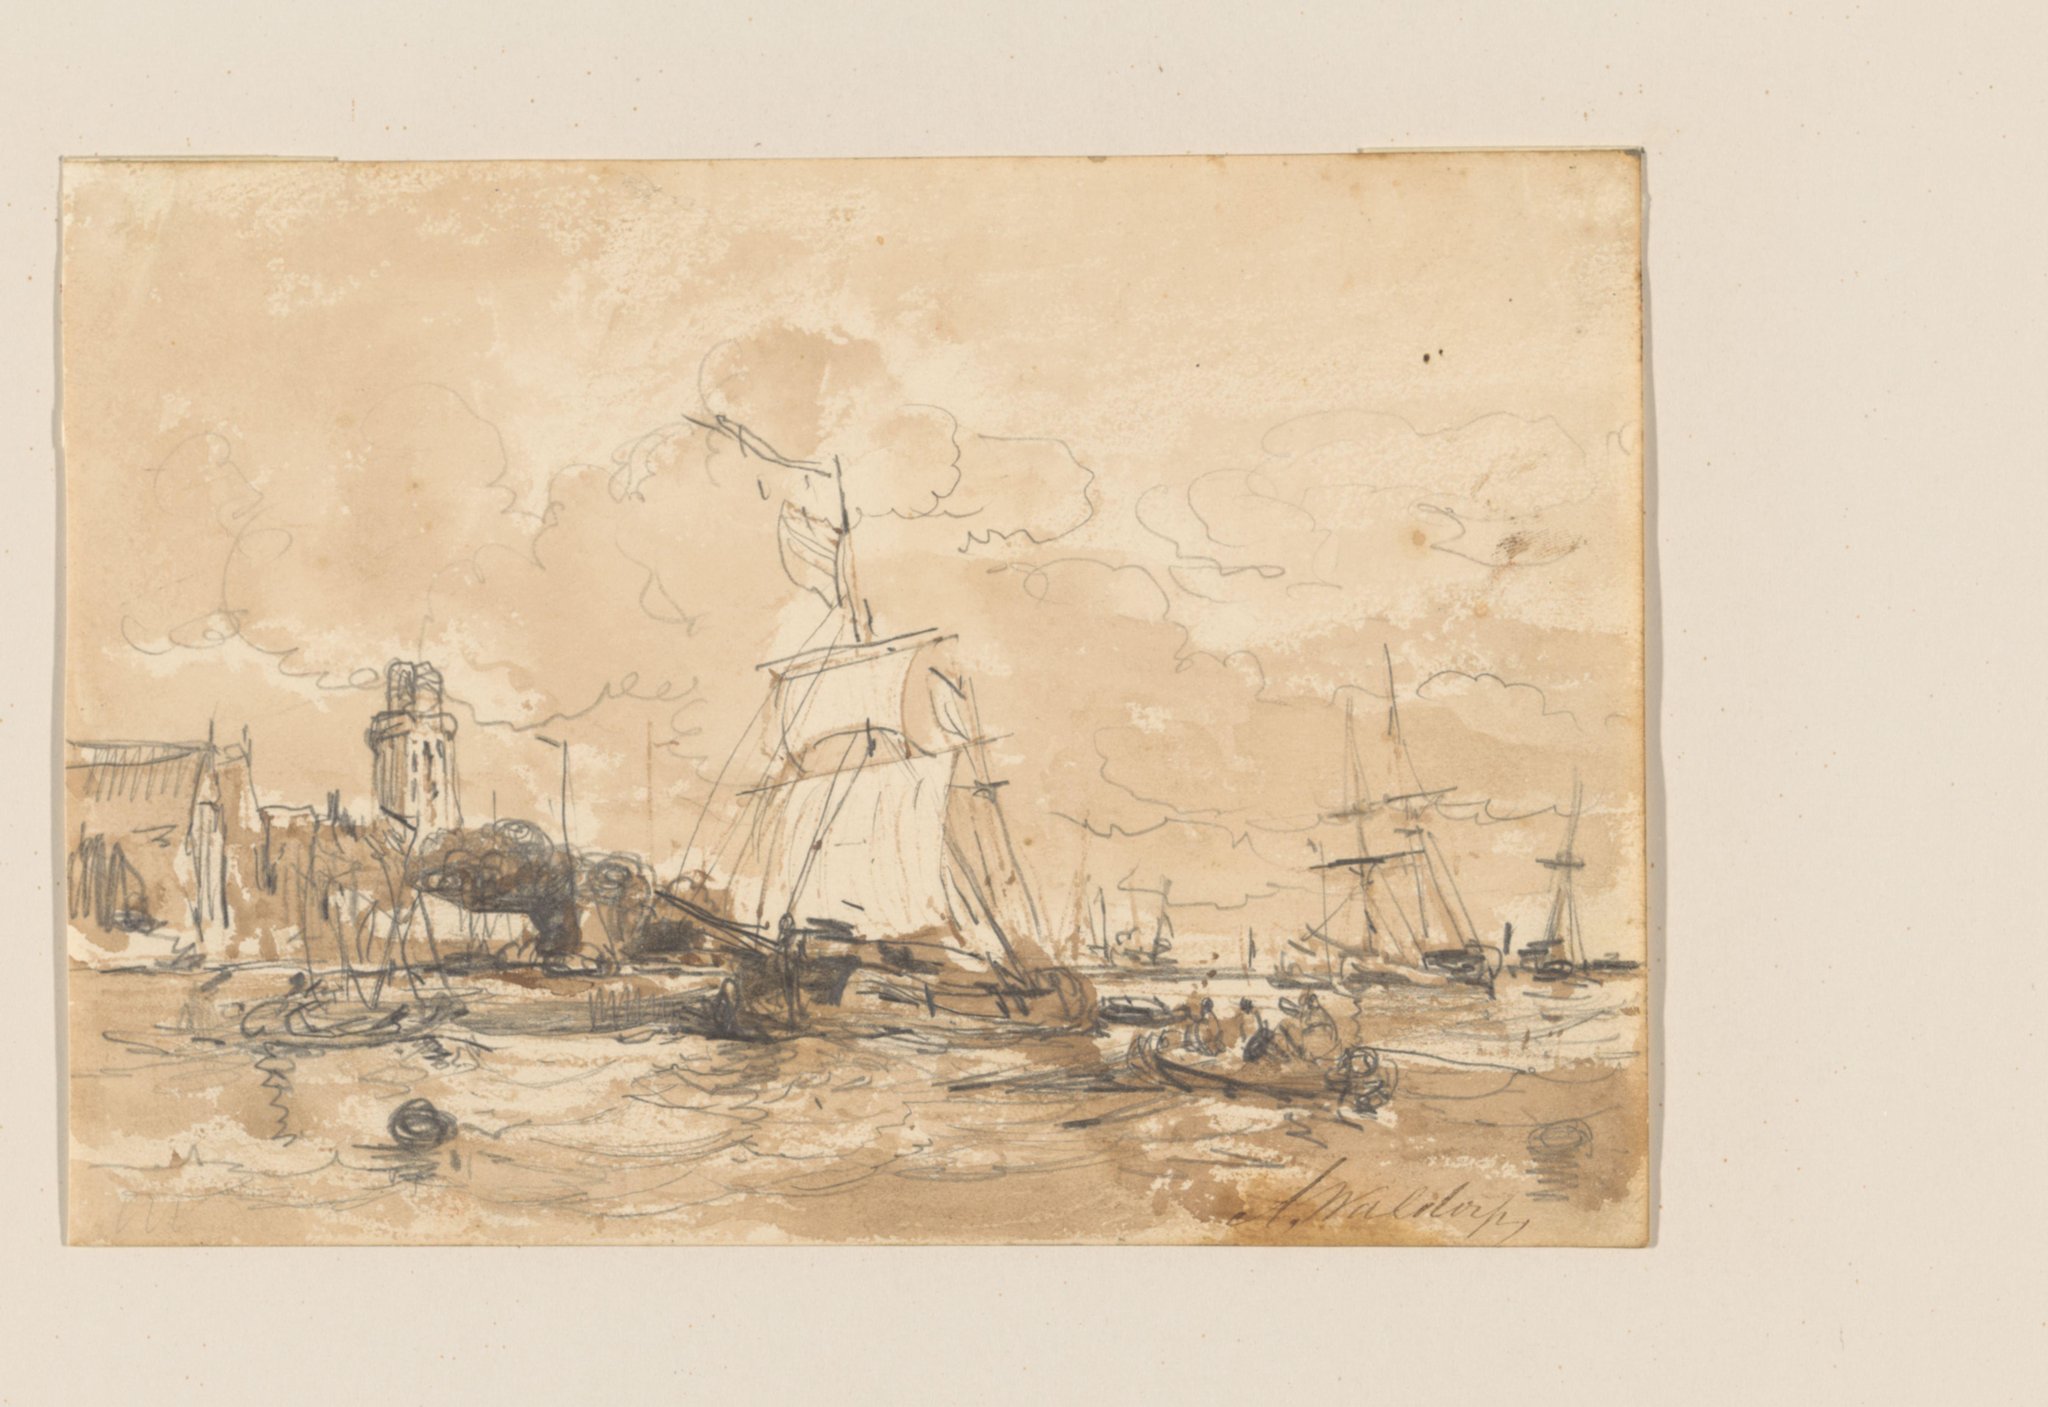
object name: drawing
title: Riviergezicht met zeilschepen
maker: antonie waldorp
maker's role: draughtsman, painter, print maker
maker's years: 1803-1866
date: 1813-1866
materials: paper, pencil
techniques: brush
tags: sailing-ship, sailing-boat, river